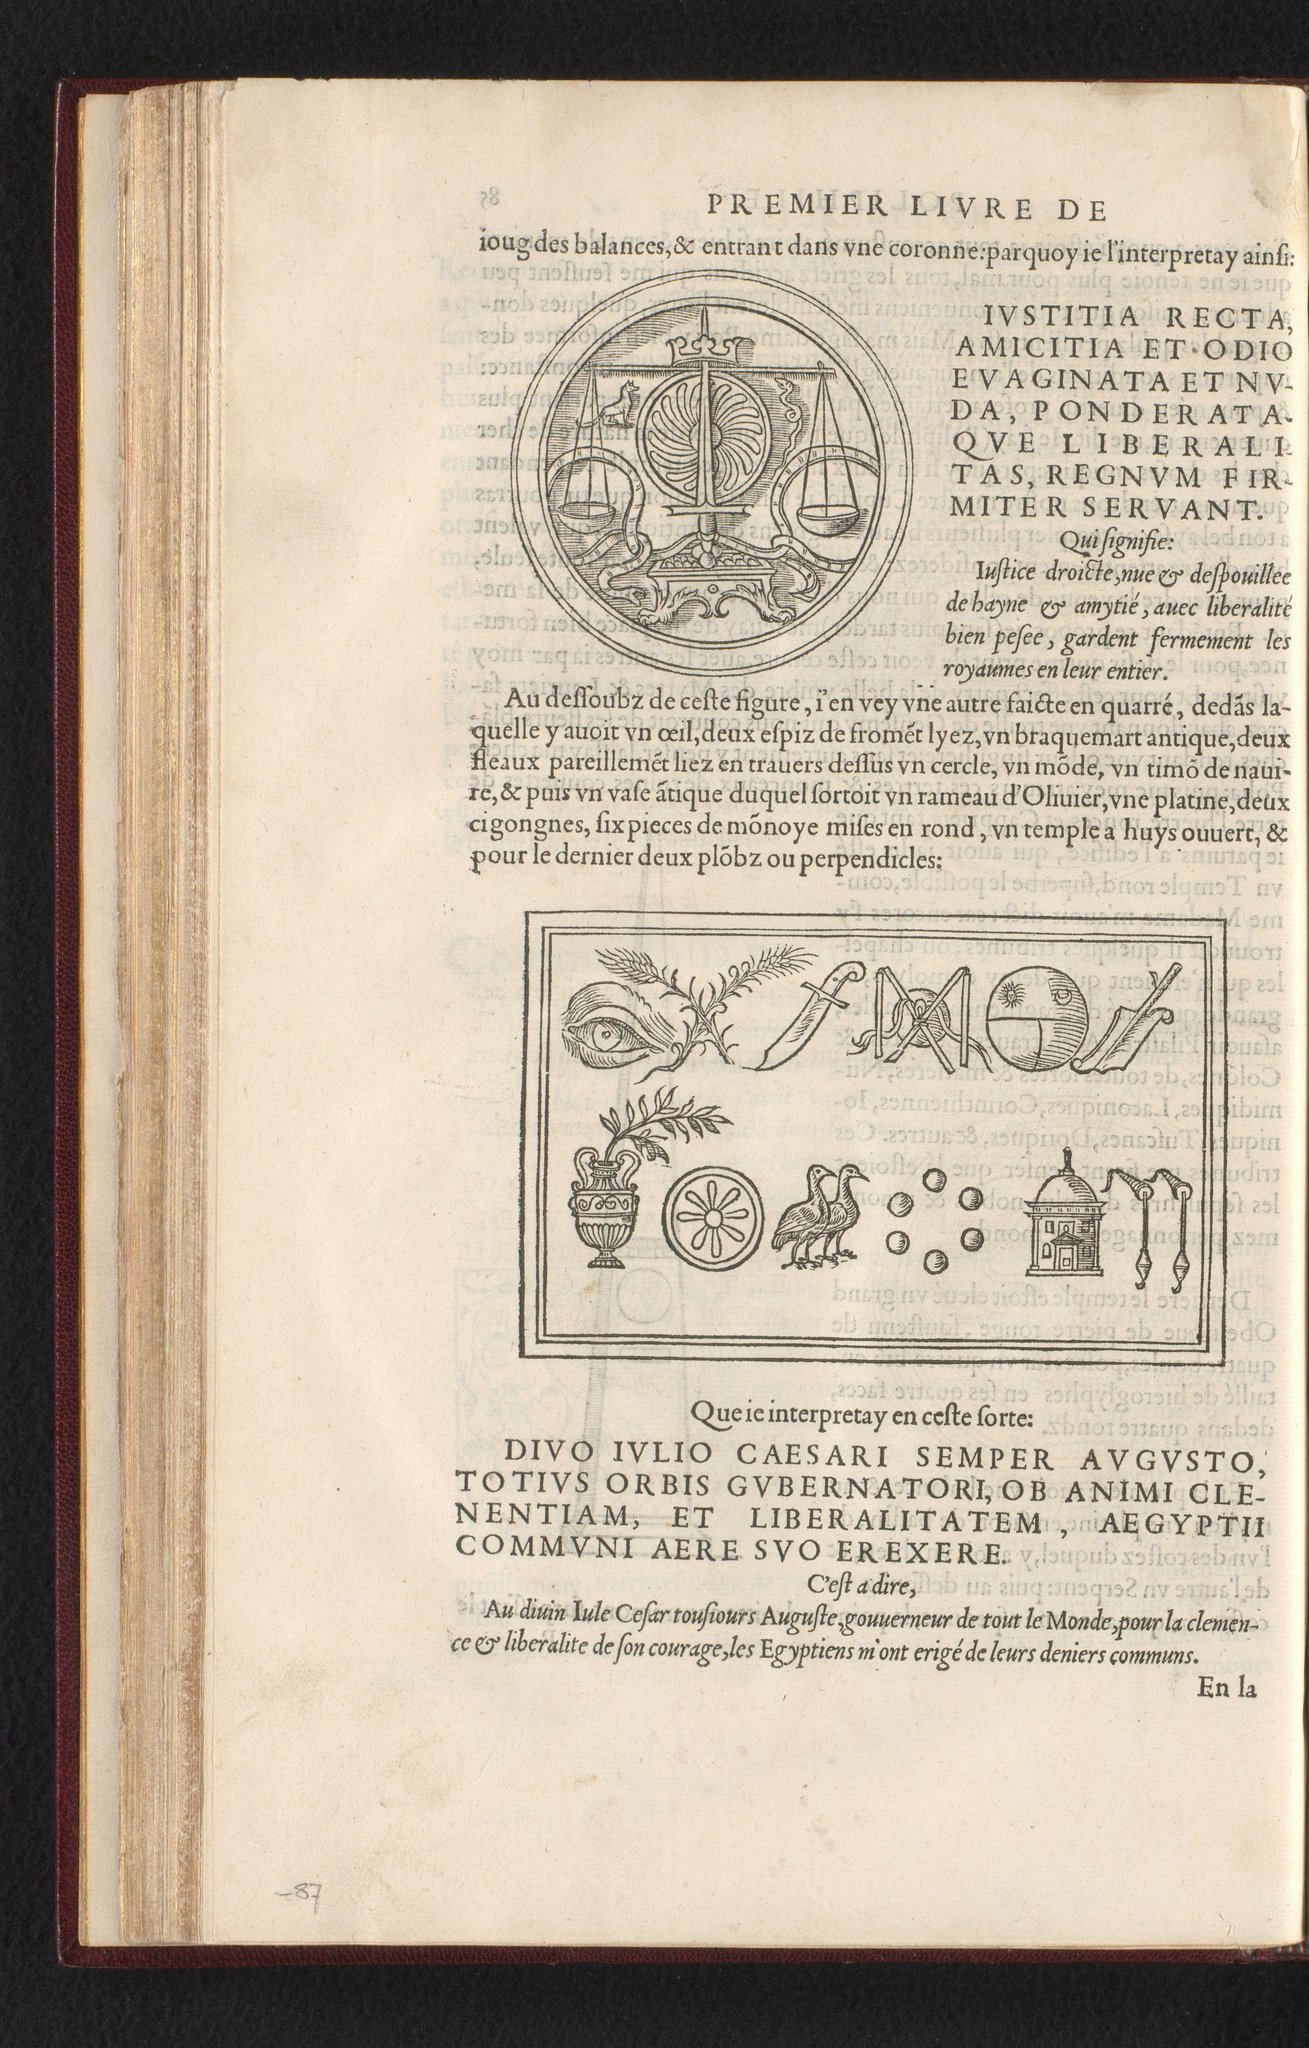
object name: print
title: Ornament met als thema gerechtigheid en een plakkaat met diverse objecten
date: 1546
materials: paper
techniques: letterpress printing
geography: paris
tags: (scenes from) specific works of literature: colonna, hypnerotomachia poliphili, (story of) c. julius caesar - representations to which the name of a person from classical history may be attached, justice; 'forza alla giustitia sottoposta', 'giustitia', 'giustitia retta', 'giustitia rigorosa', 'impietà e violenza soggetta alla giustitia' (ripa), symbols and allegories of jurisprudence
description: Prent uit: Colonna, Francesco. Hypnerotomachie ou discours du songe de Poliphile, deduisant comme amour le combat a l'occasion de Polia. Parijs: Jacques Kerver, 1546, verso fol. 85.